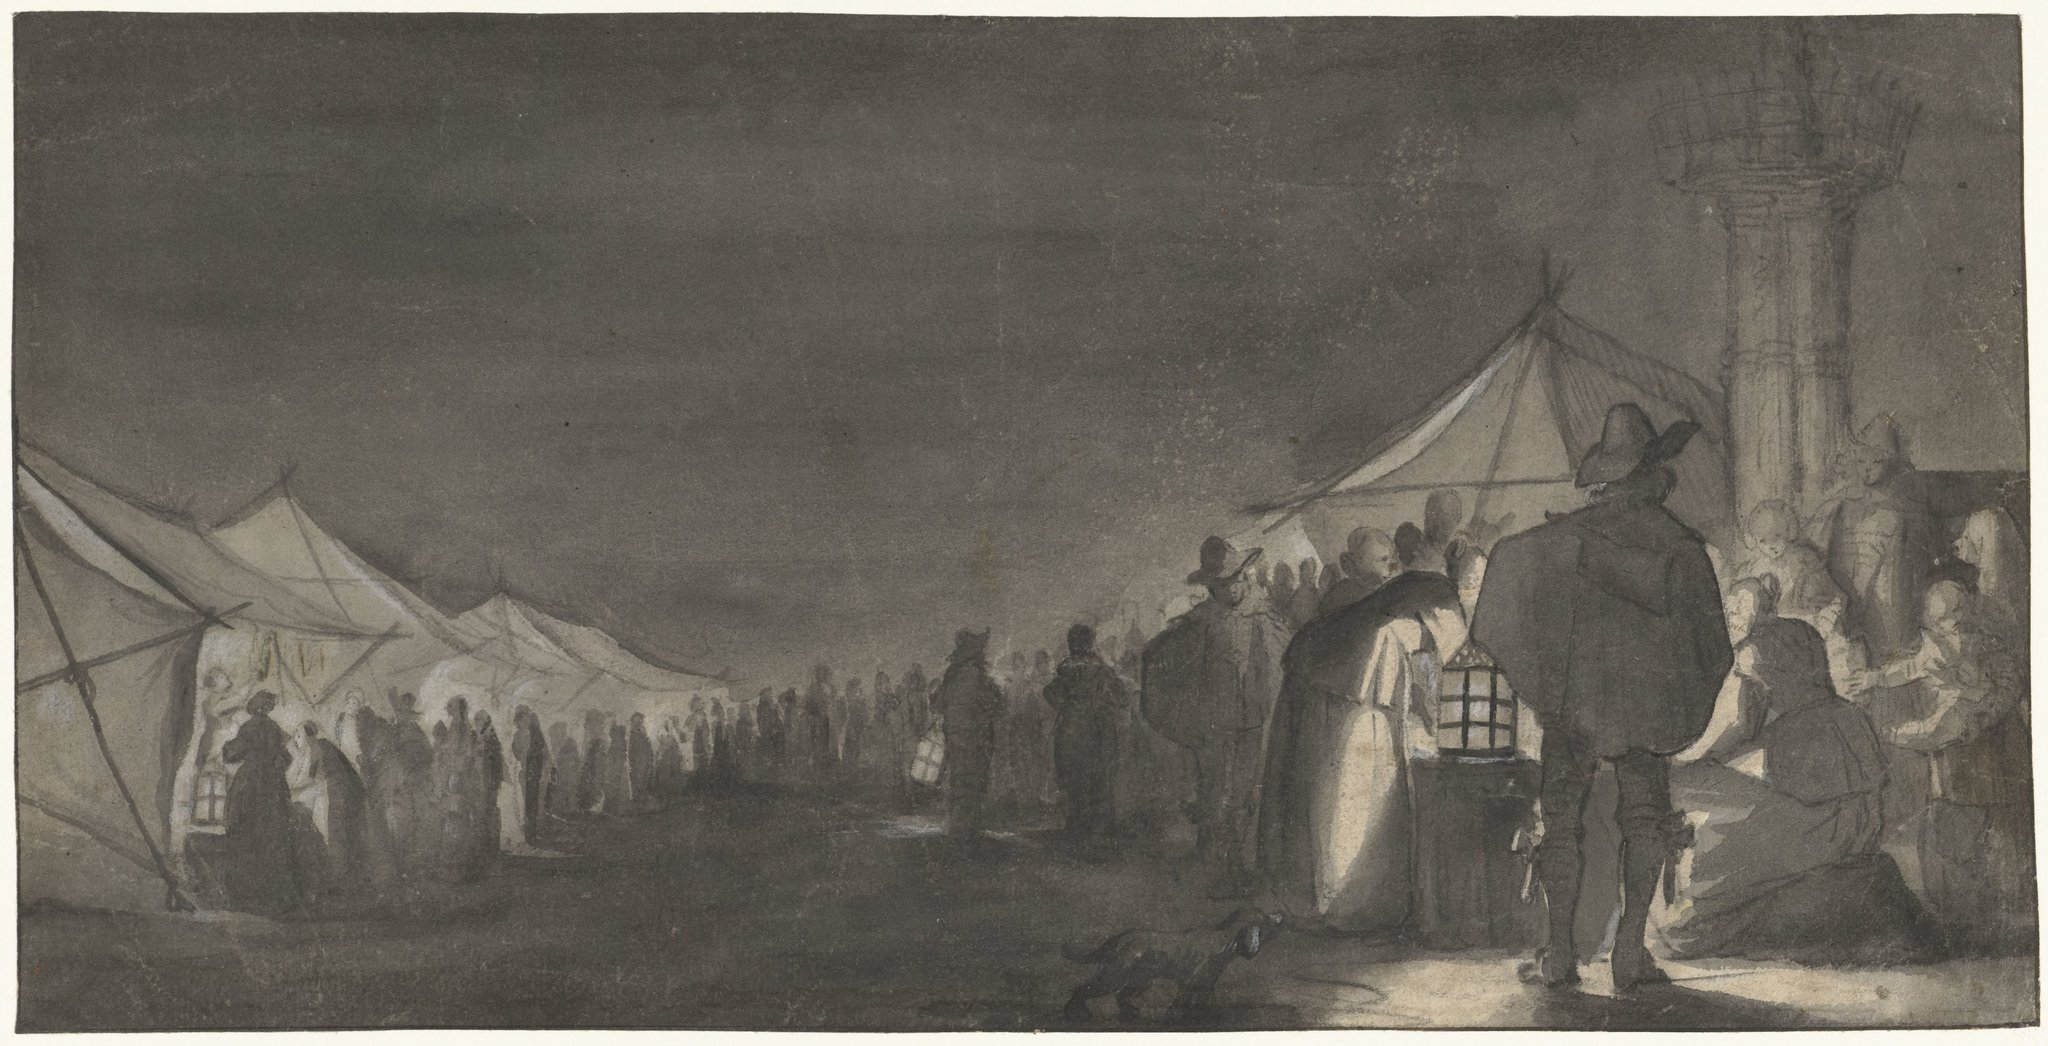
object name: drawing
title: De Melkmarkt in Zwolle, bij avond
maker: gerard ter borch (ii)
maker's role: draughtsman, painter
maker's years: 1617-1681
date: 1635-1640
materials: chalk, paint, gouache, ink, paper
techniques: brush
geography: zwolle